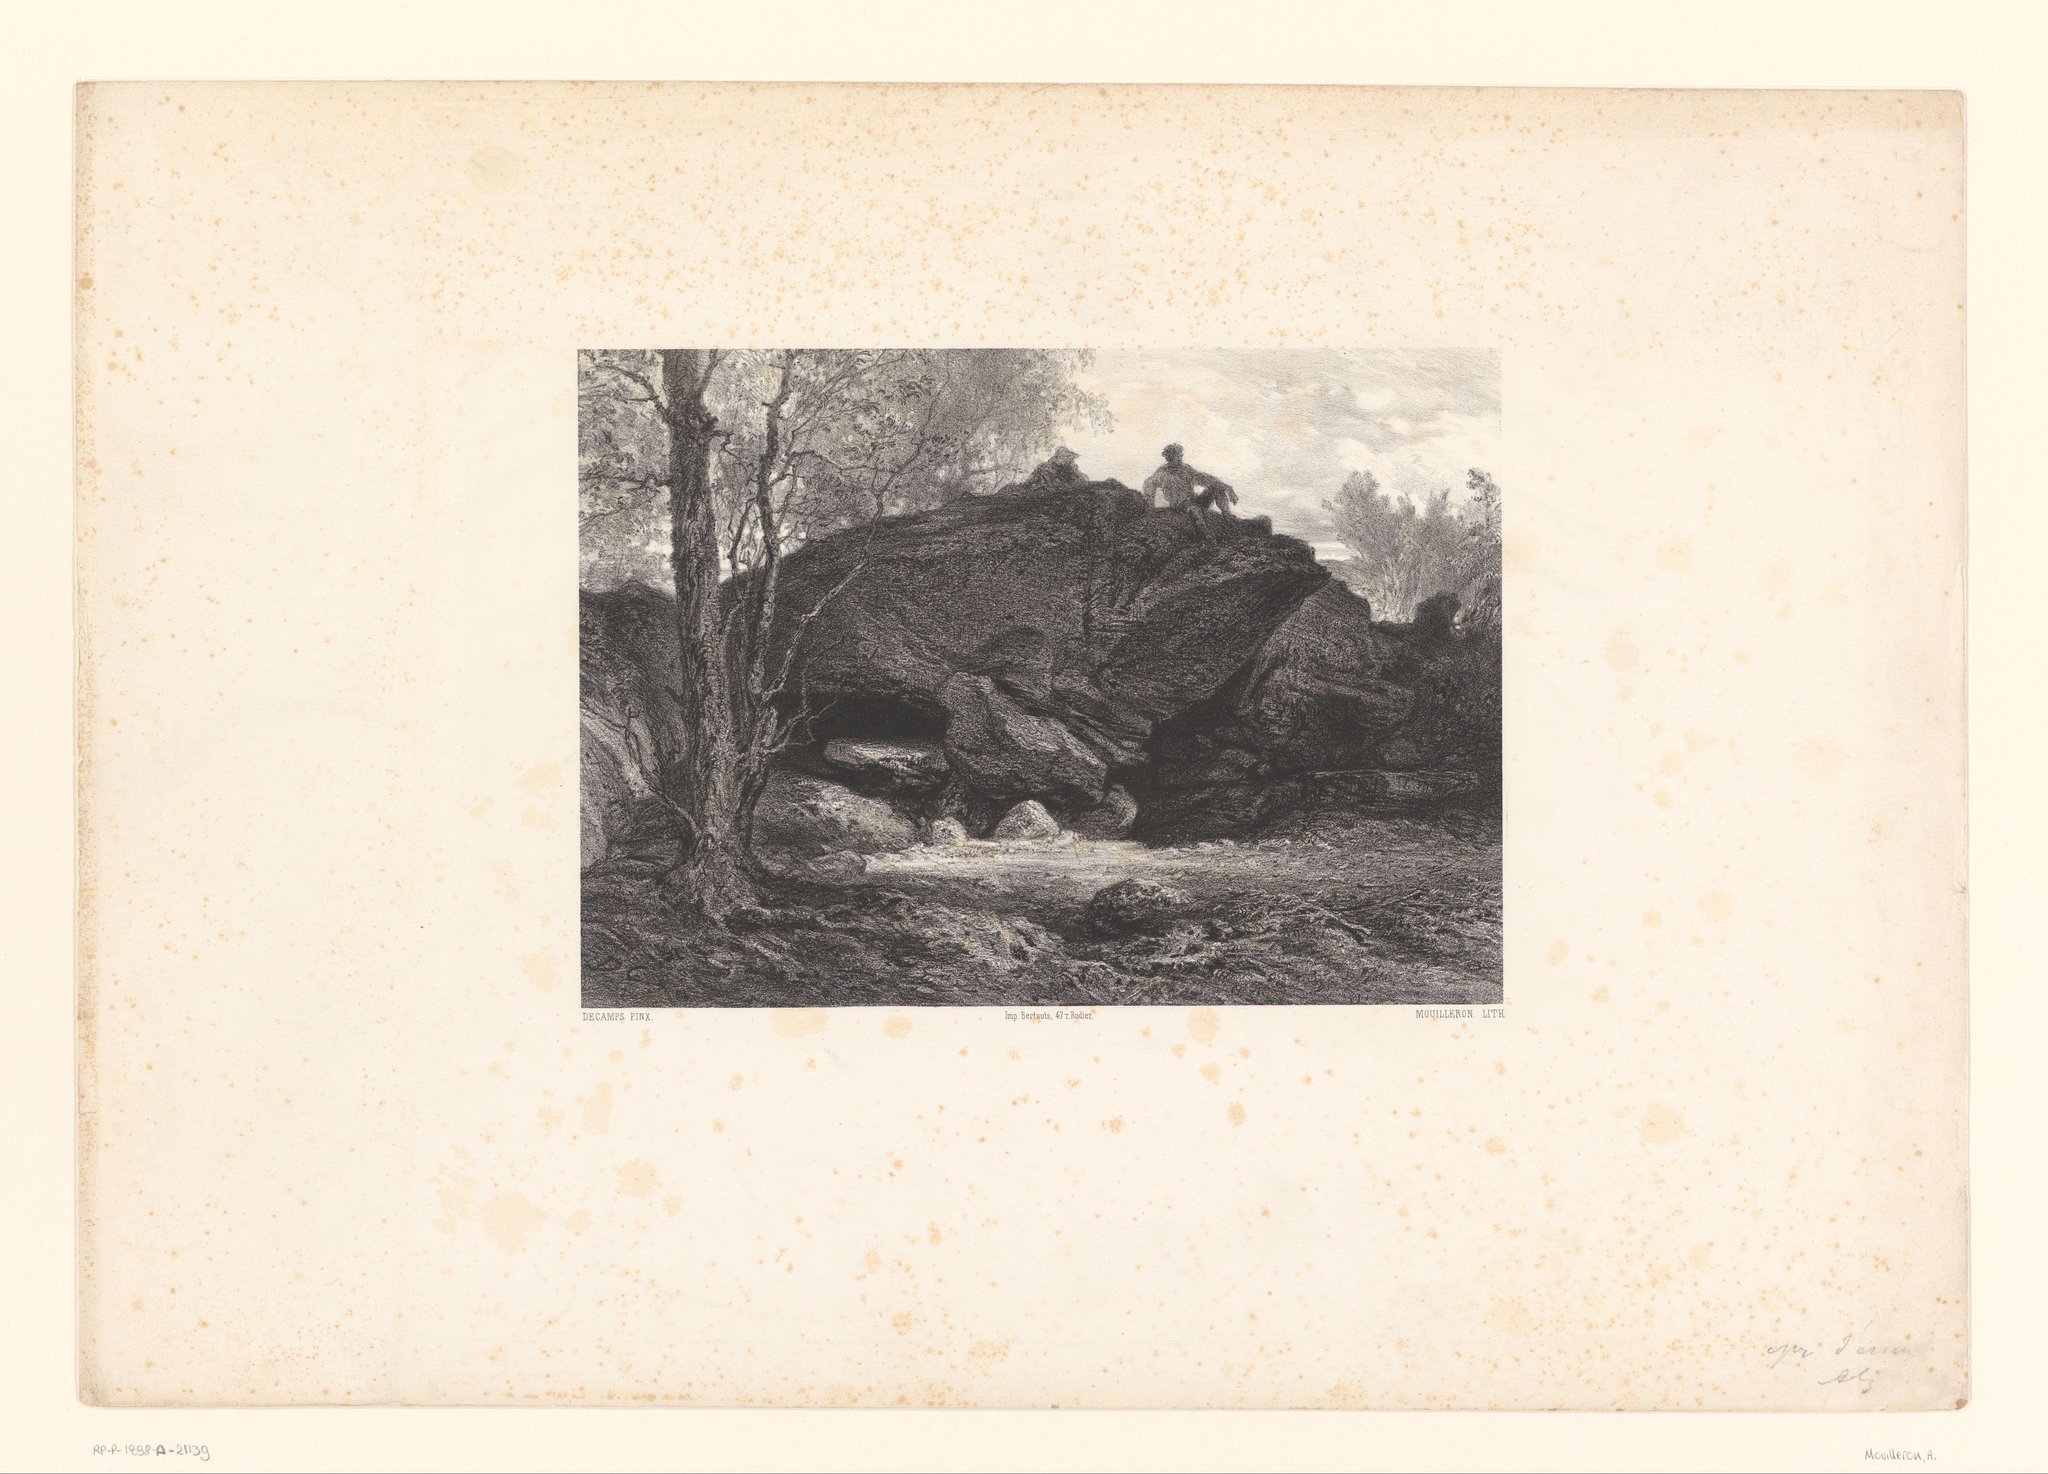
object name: print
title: Twee mannen op een rotspartij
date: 1830-1880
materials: paper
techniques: lithograph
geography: paris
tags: trees, sitting figure, rock-formations, lying figure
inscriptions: inscription: ‘epr d'essai/ AM’, collector's mark: Lugt 963